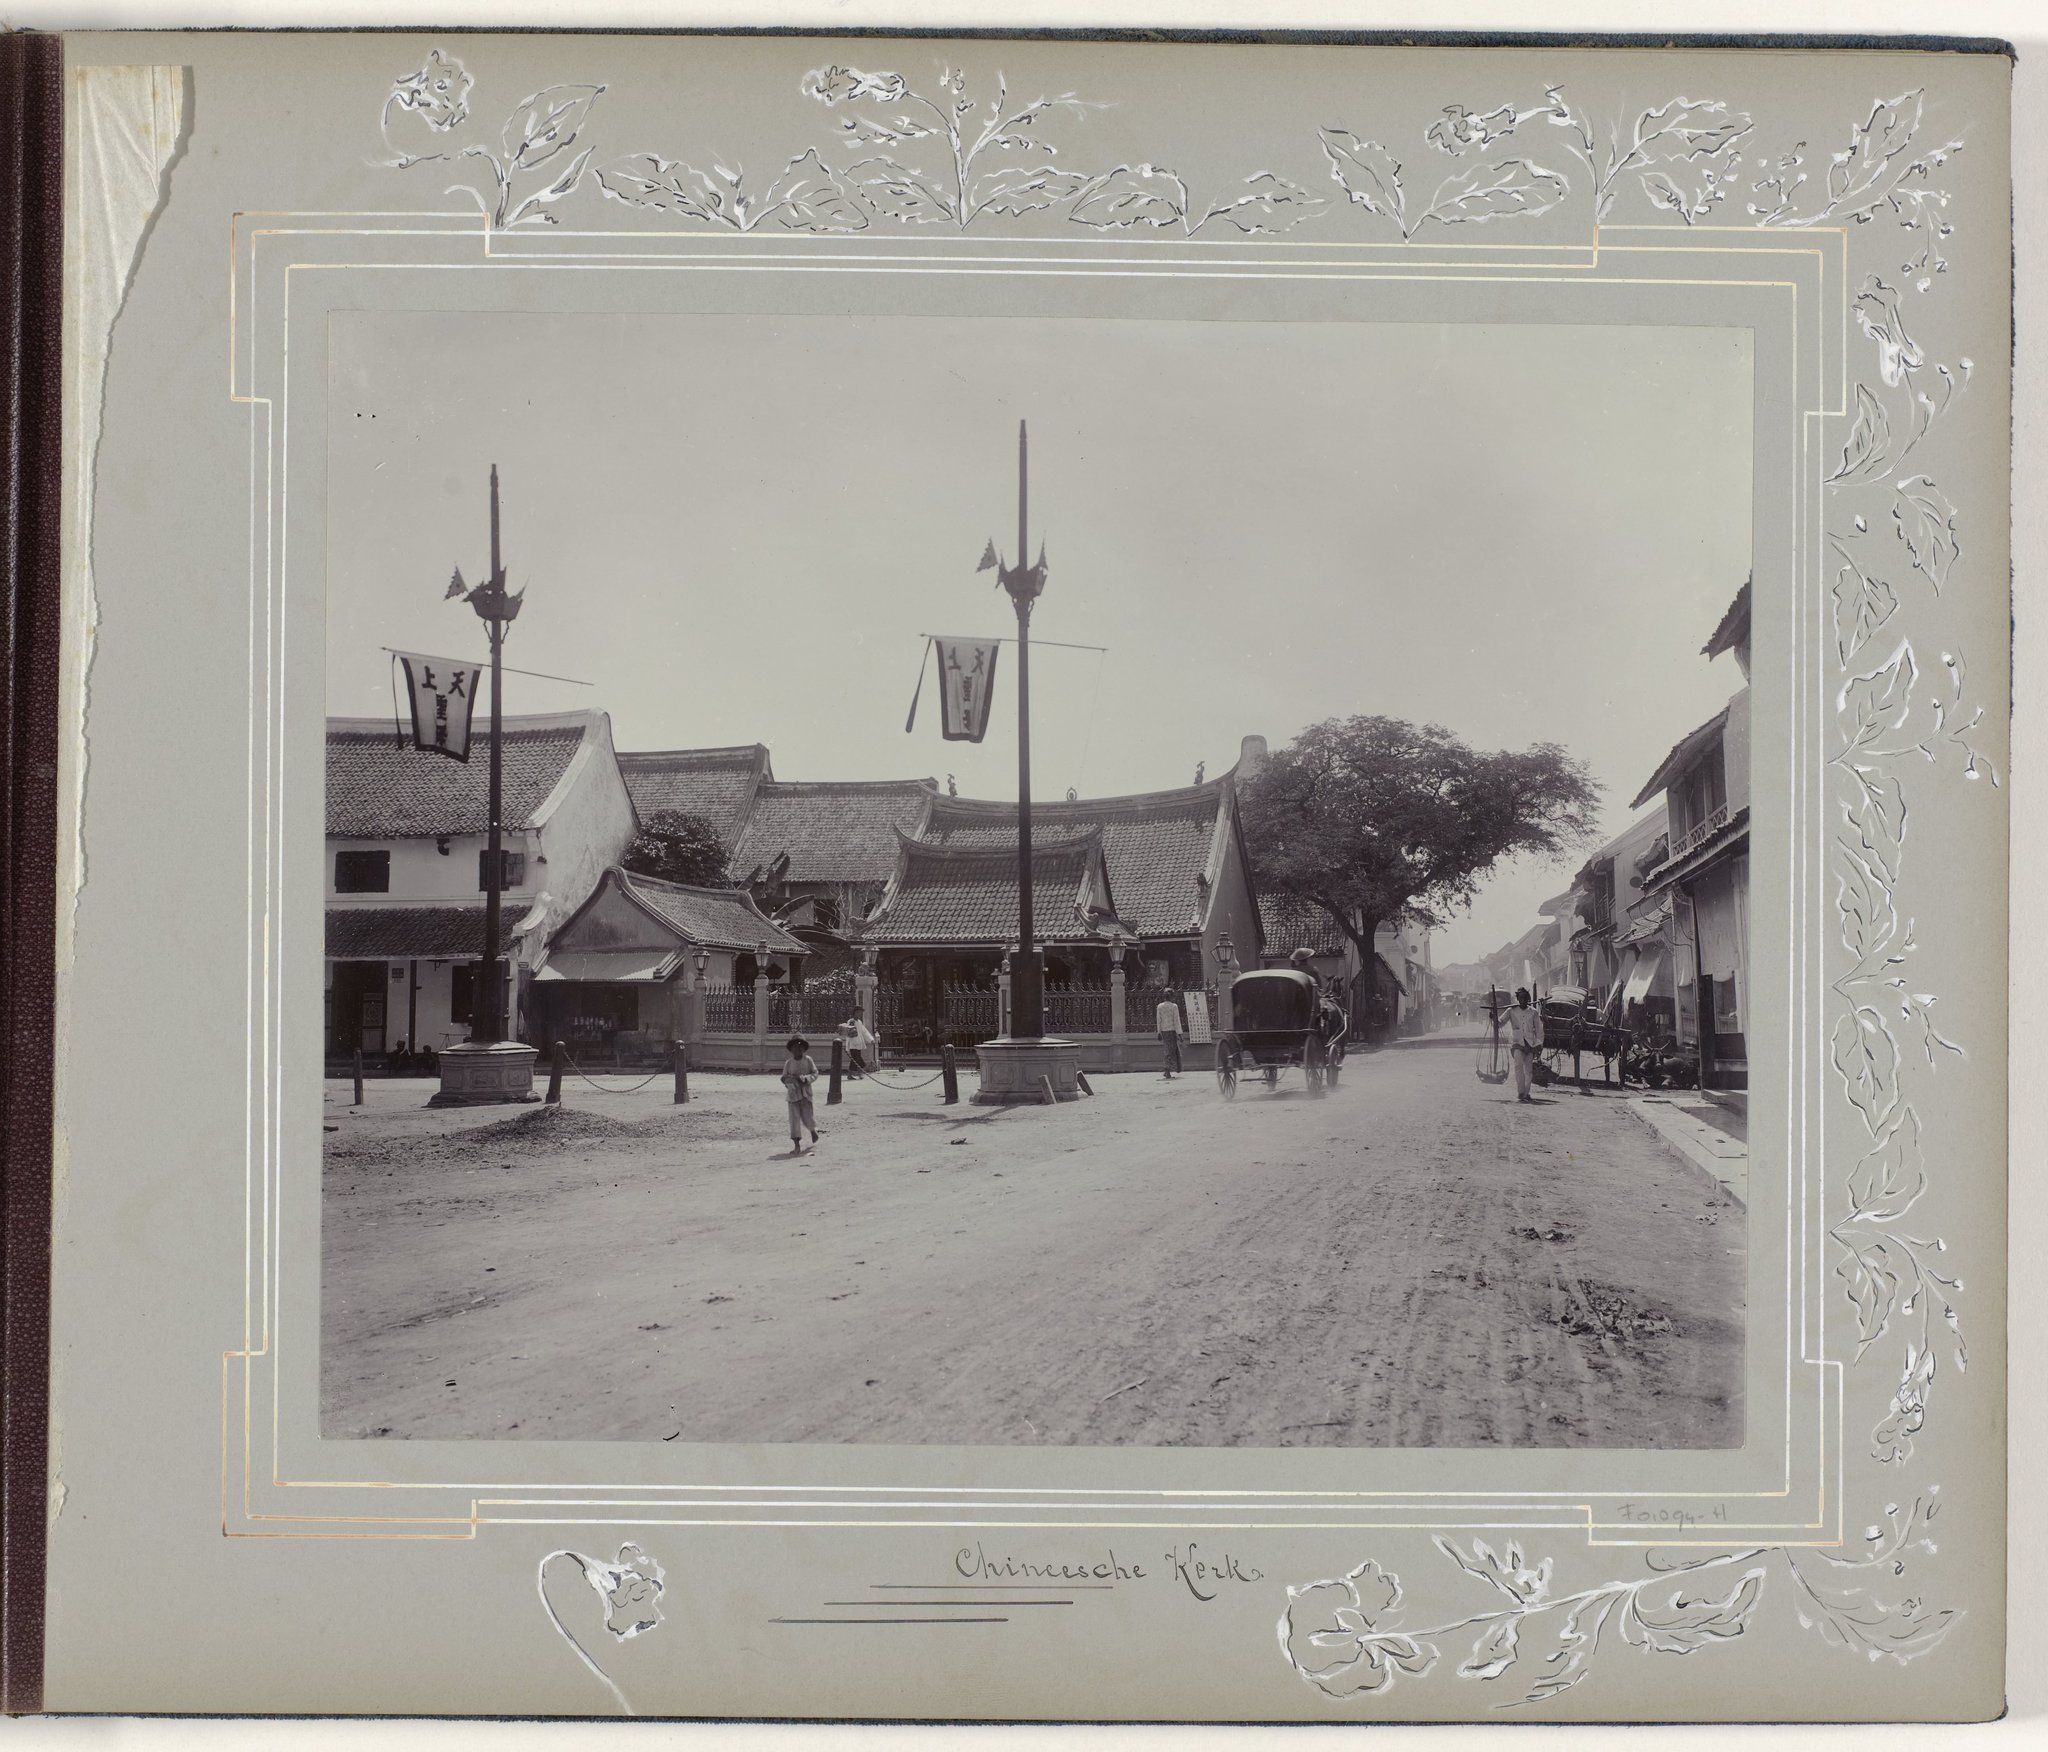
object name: photograph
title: Chineesche Kerk.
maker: Anonymous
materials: cardboard, paper, photographic support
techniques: gelatin silver print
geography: surabaya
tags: carrying something with carrying-pole, church (exterior), street (+ city(-scape) with figures, staffage), surabaya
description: Onderdeel van Herinneringsalbum met foto's van Soerabaja.